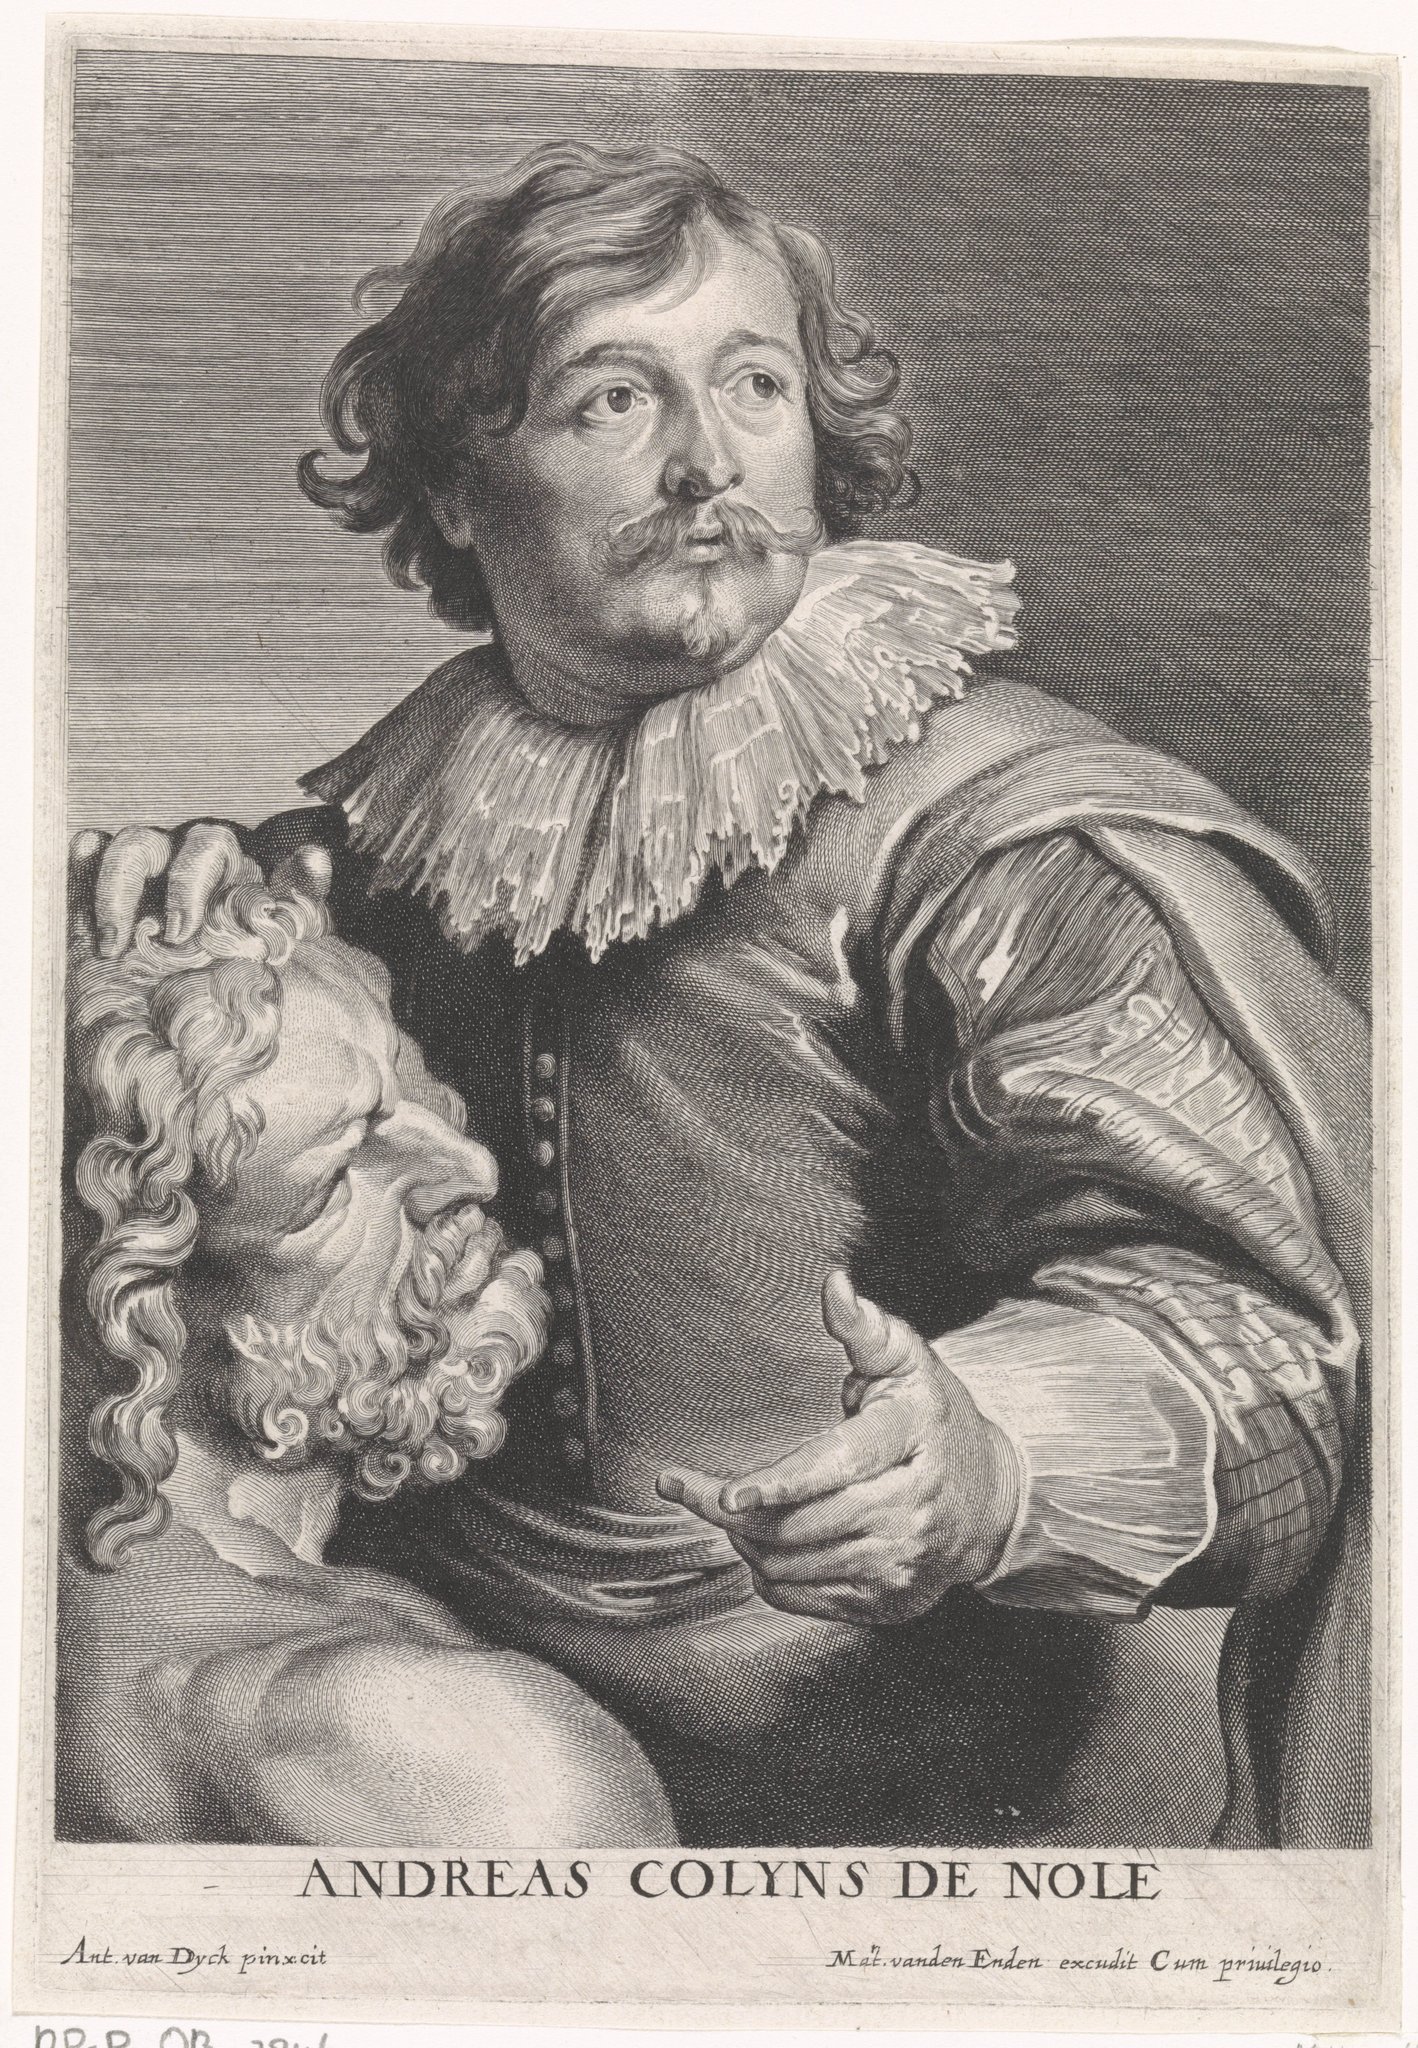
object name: print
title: Portret van Andreas Colijns de Nole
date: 1628-1670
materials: paper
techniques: engraving, etching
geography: antwerp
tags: antwerp, sculptor, andreas de nole, piece of sculpture, reproduction of a piece of sculpture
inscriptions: collector's mark: Lugt 240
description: Portret van de beeldhouwer Andreas Colijns de Nole, ten halven lijve. Met zijn rechterhand leunt hij op een marmeren beeld. In de marge de naam van de geportretteerde.